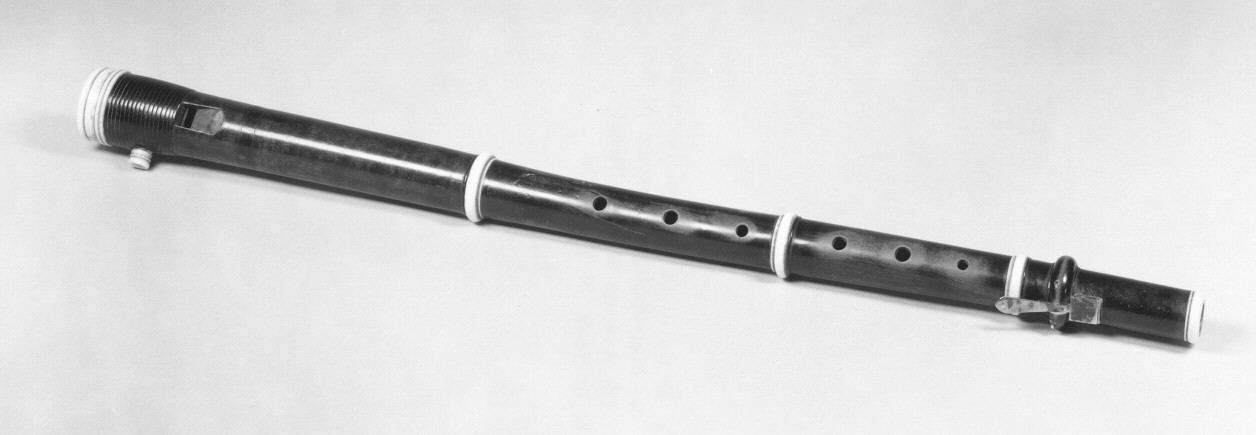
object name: flageolet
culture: american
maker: frederick riley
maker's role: maker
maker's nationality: american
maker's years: 1800-1900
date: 1844-1850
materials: wood, brass, ivory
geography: united states